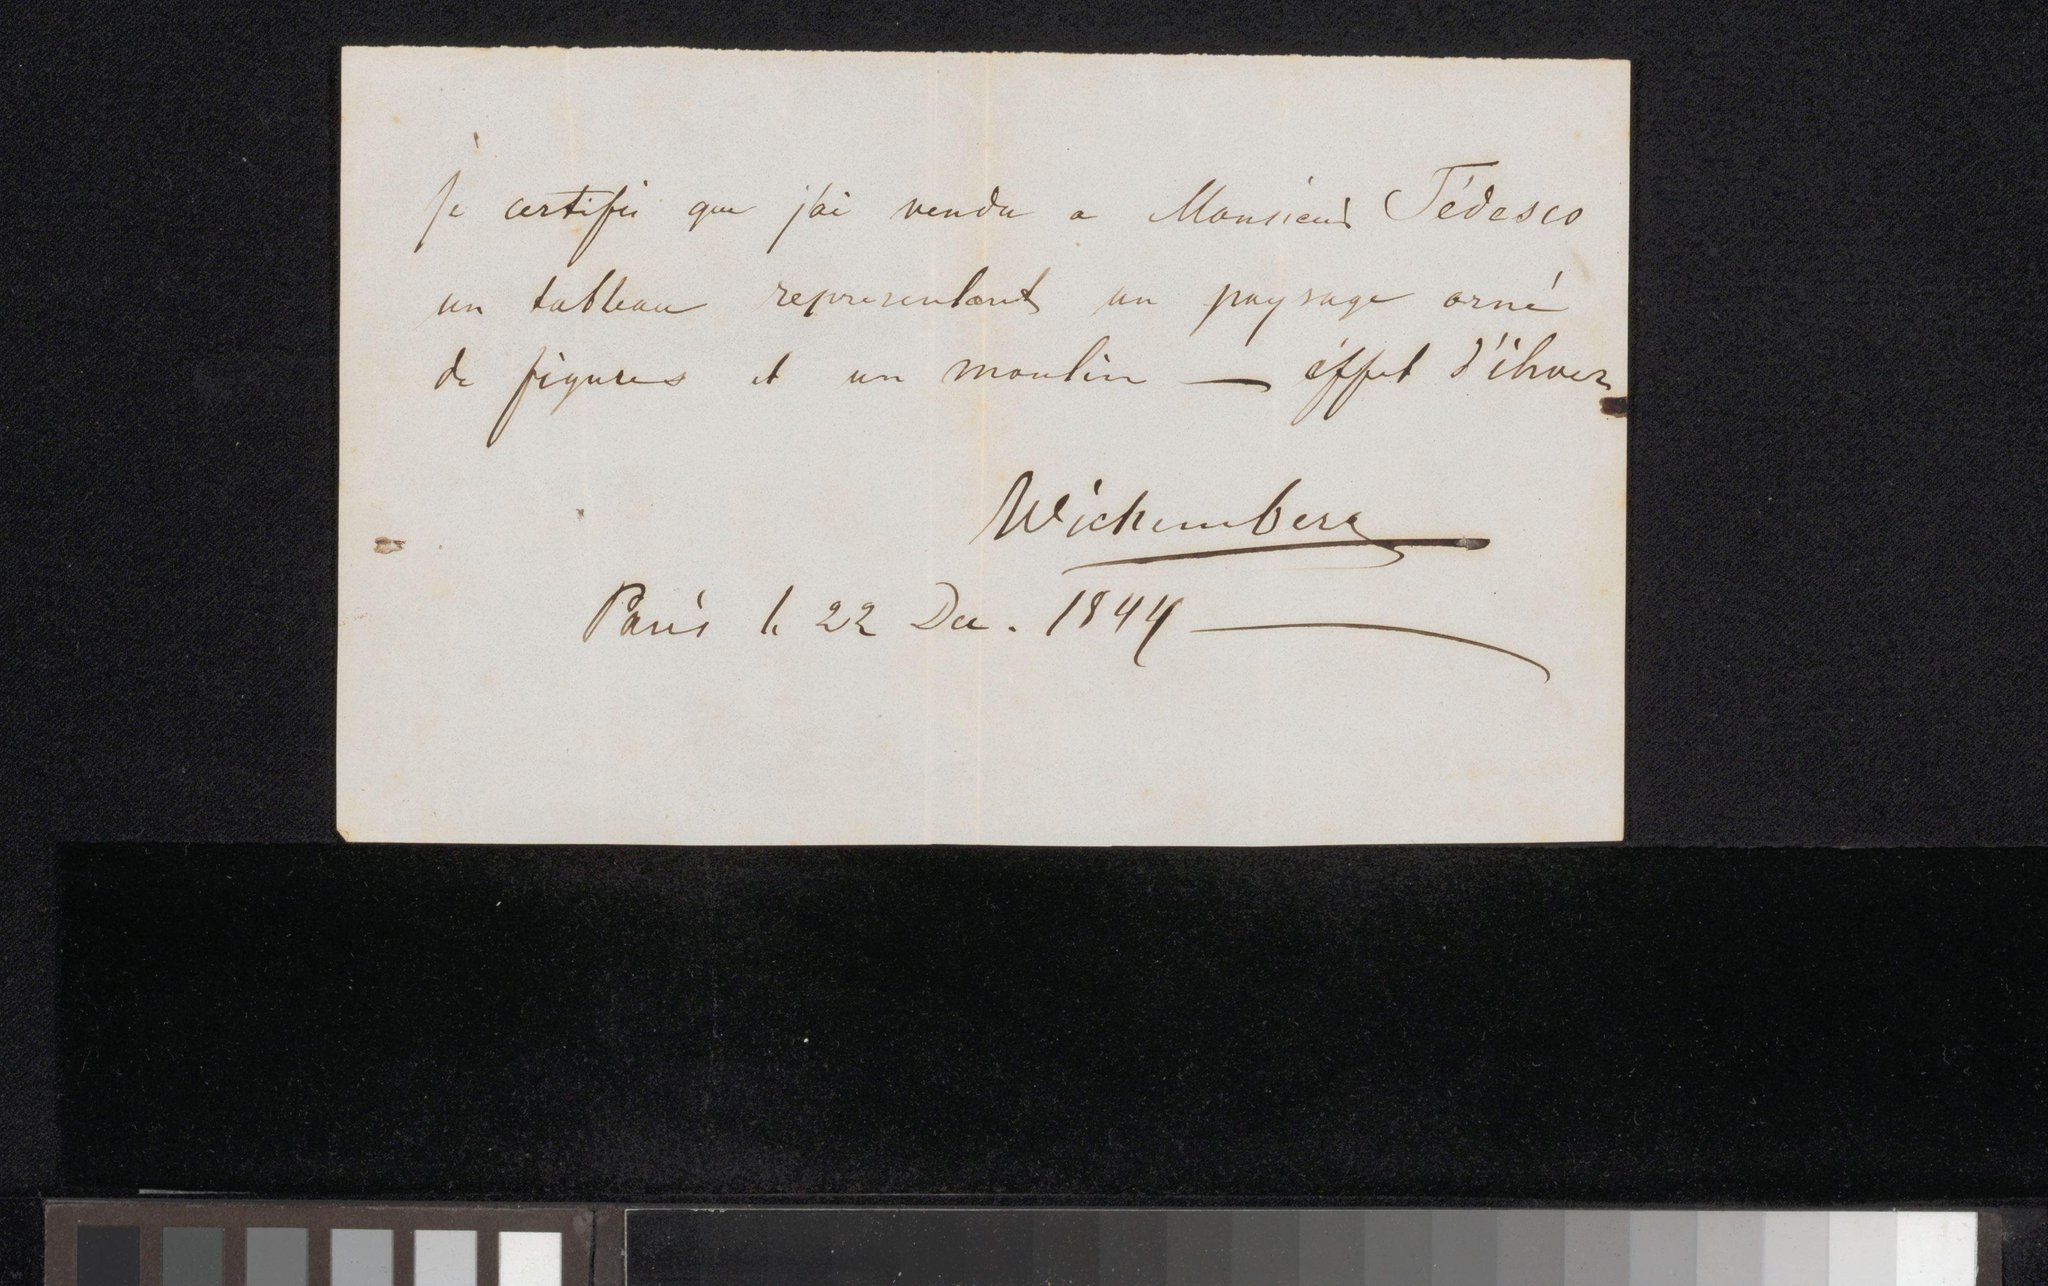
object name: letter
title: Brief aan anoniem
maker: wichemberg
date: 1844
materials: ink, paper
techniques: pen, writing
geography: paris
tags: art trade, art shop, painting (including book-illumination, miniature-painting)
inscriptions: collector's mark: Lugt 2228